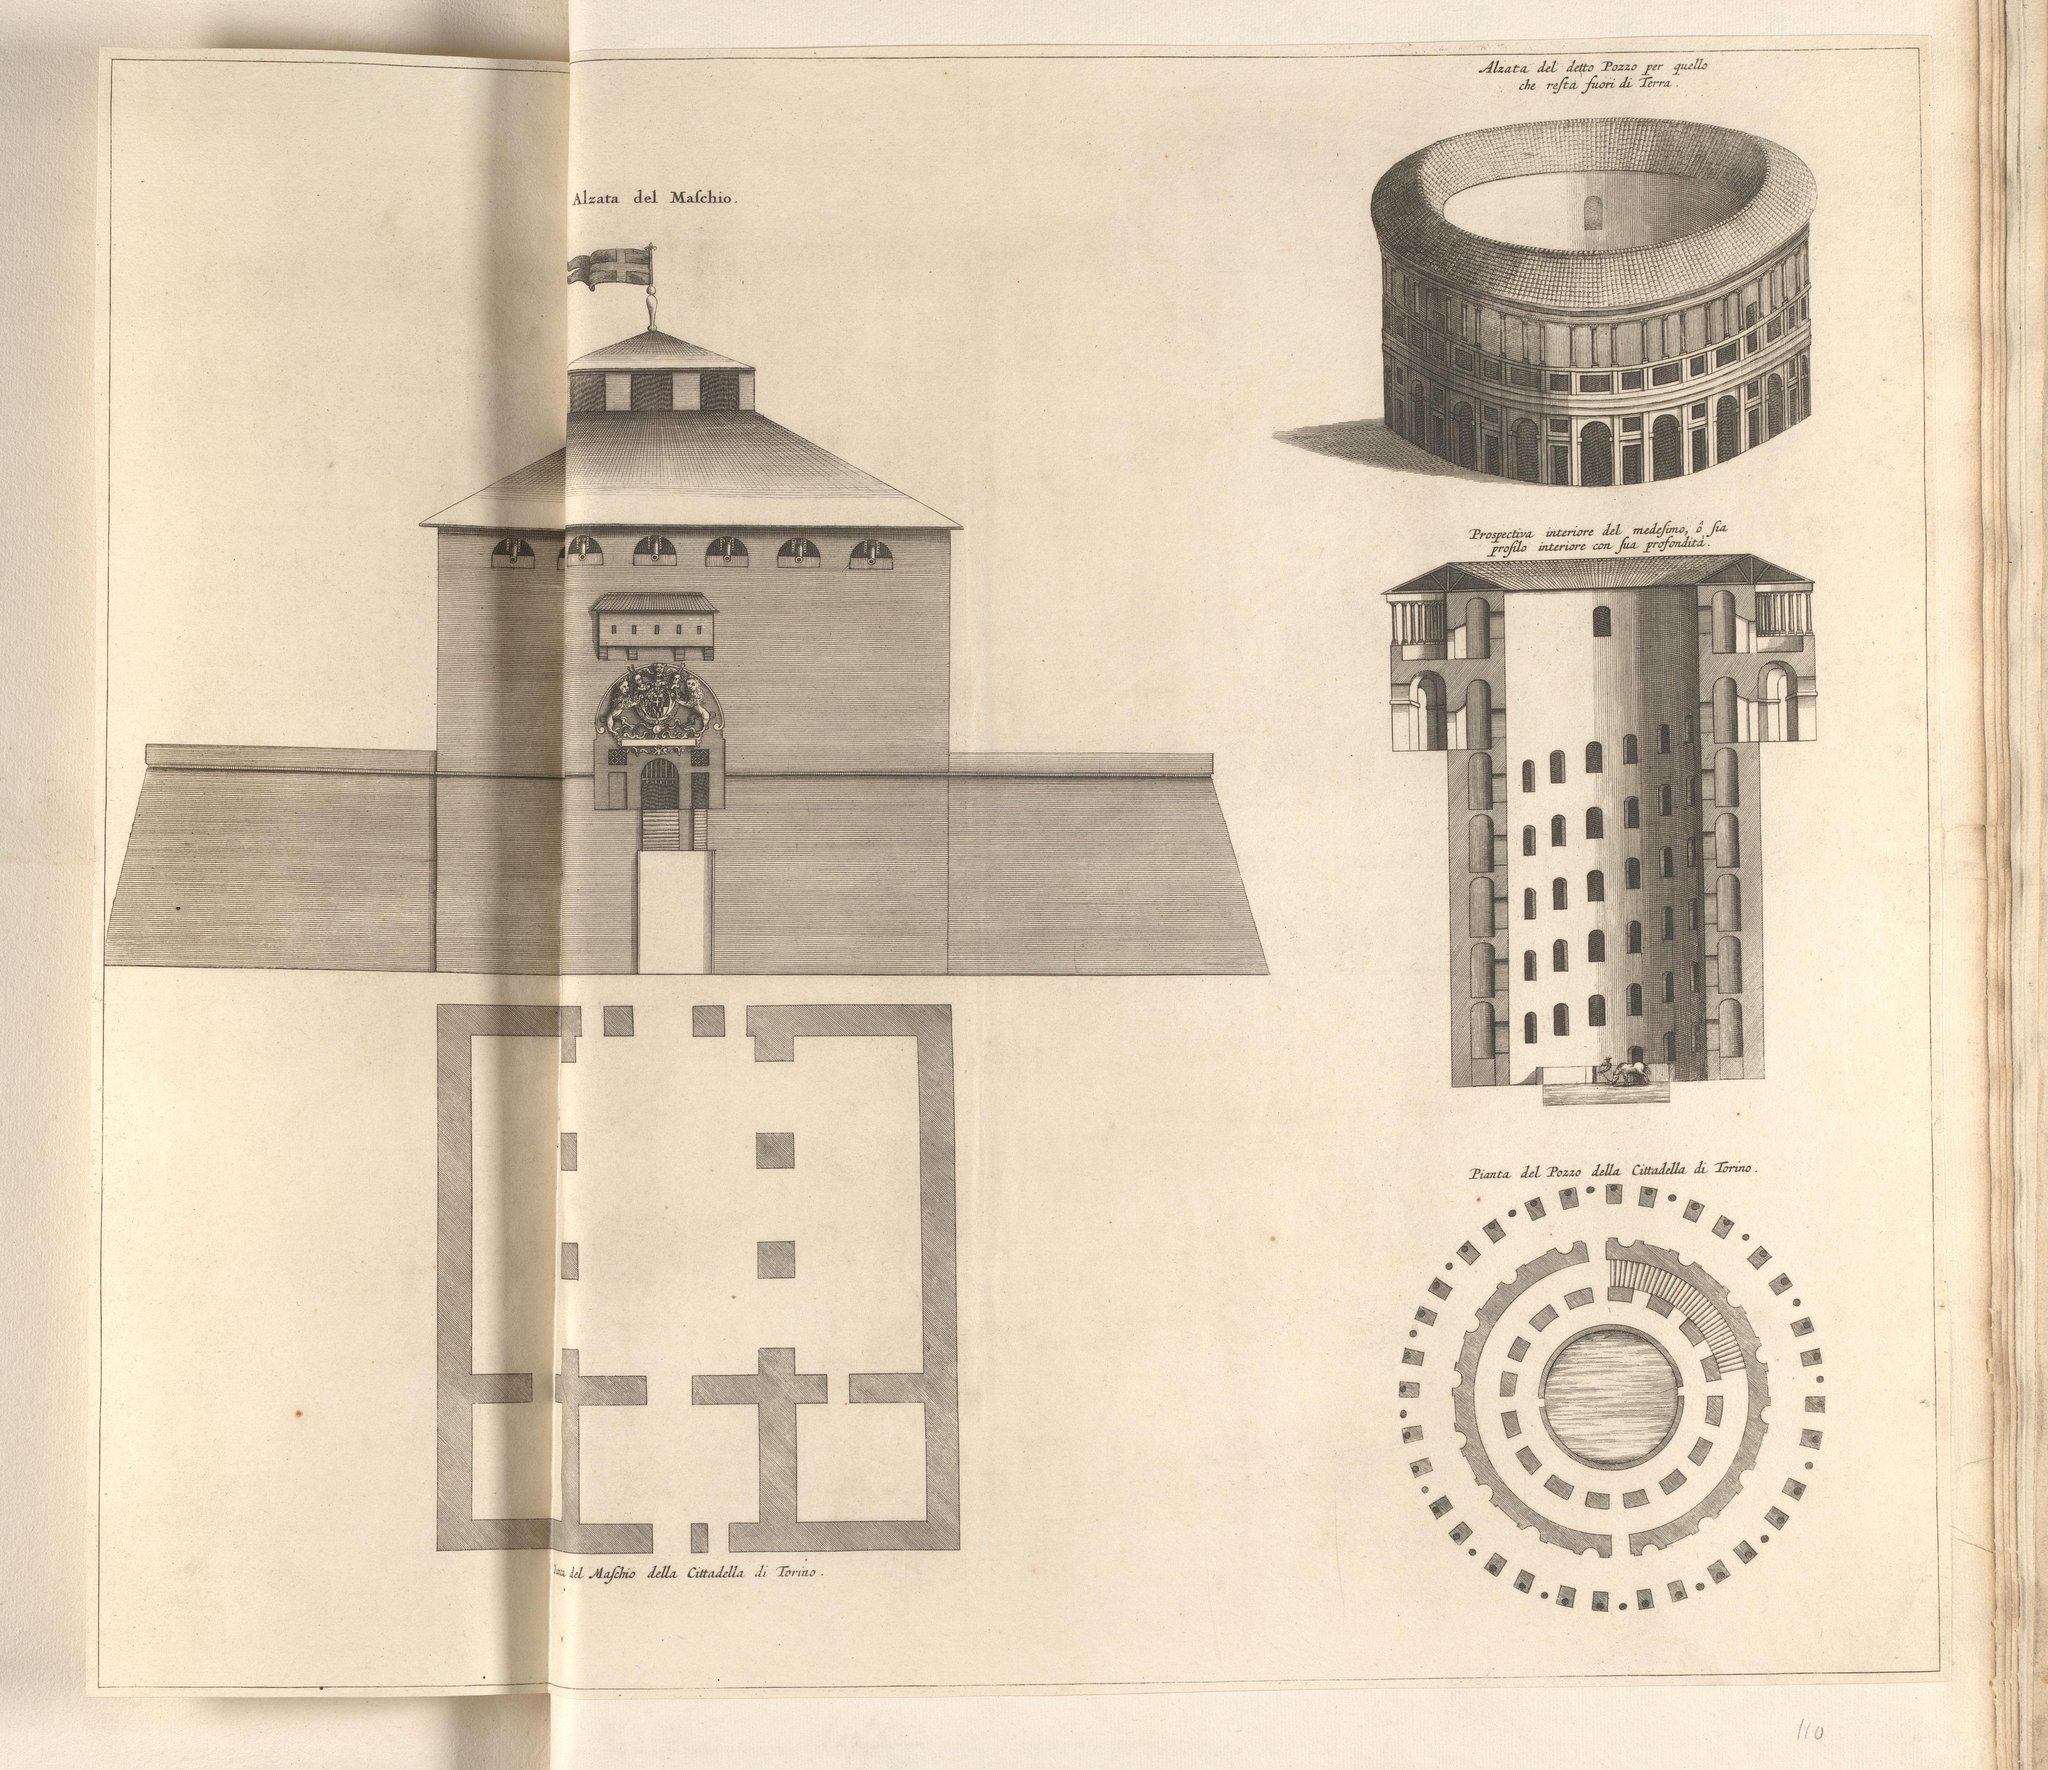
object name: print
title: Citadel en de grote put van Turijn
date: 1682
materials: paper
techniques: etching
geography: amsterdam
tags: well, representation of real building (either existing or having existed), fortified city, permanent fortifications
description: Deze prent maakt deel uit van een reeks met bouwwerken binnen het domein van de Savoie-familie in de late 17e eeuw.